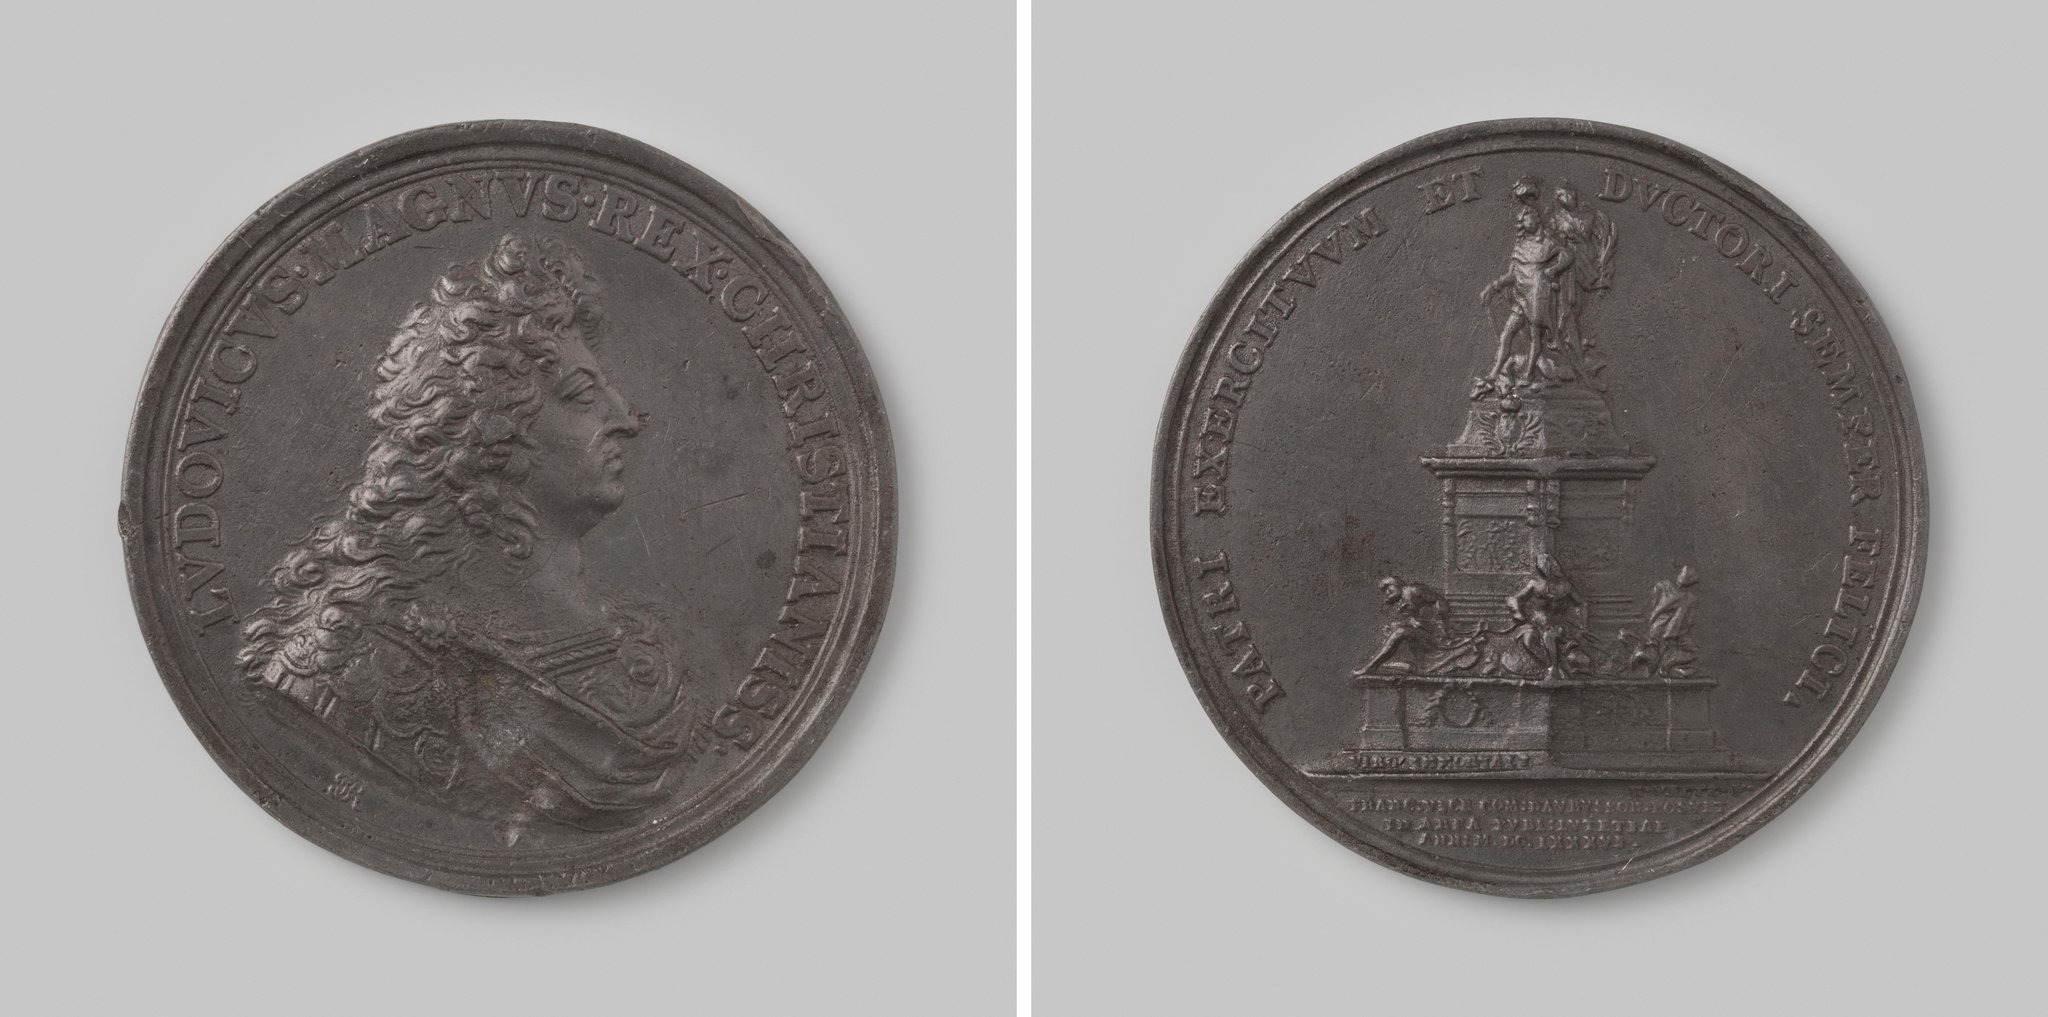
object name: history medal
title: Oprichting van het standbeeld van Lodewijk XIV te Parijs 1686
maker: jean roëttiers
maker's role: medailleur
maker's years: 1631-1703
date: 1686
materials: tin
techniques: casting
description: Tinnen afgietsel van een penning, op de voorzijde het borstbeeld van Koning Lodewijk XIV van Fankrijk naar rechts met omschrift, op de keerzijde een standbeeld op sokkel met omschrift en afsnedetekst.